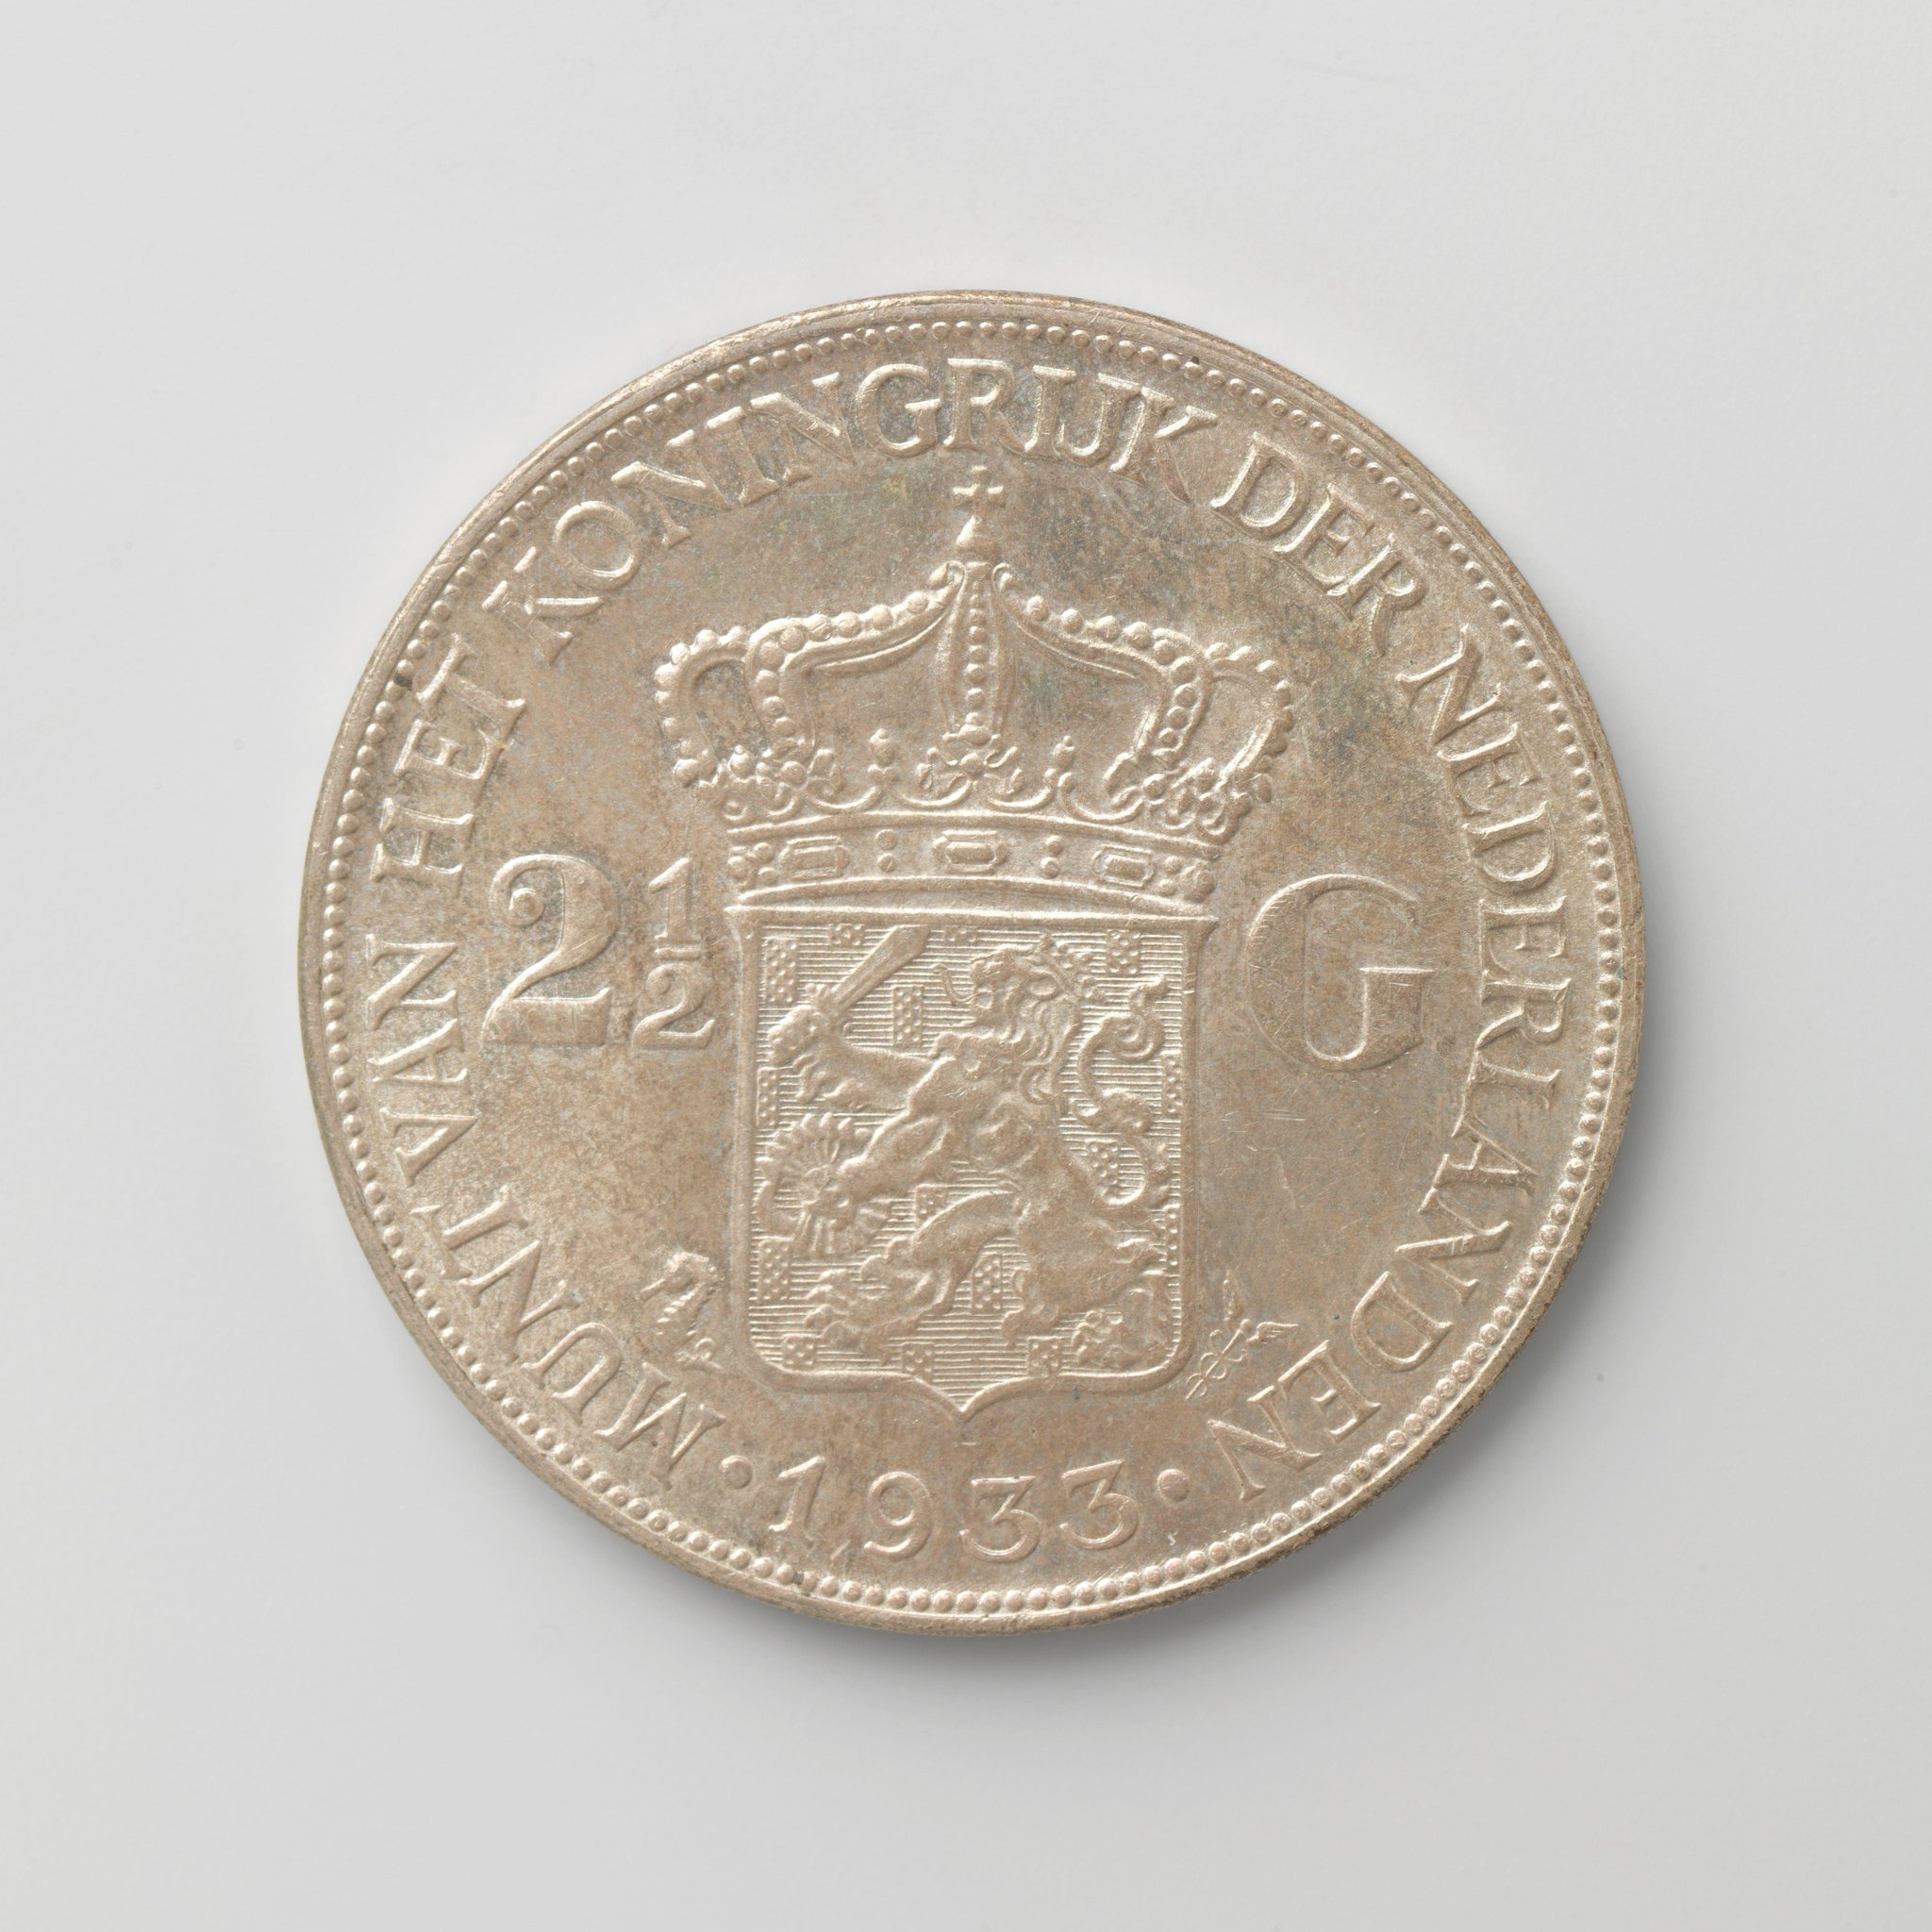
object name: coin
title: Nederland, 2½ gulden,1933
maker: wilhelmina of the netherlands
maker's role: print maker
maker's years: 1880-1962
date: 1933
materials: silver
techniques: striking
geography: utrecht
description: Zilveren munt. Voorzijde: hoofd naar links. Keerzijde: tussen waarde-aanduiding 2½ G gekroond rijkswapenschild. Jaartal onderaan in omschrift. Randschrift.